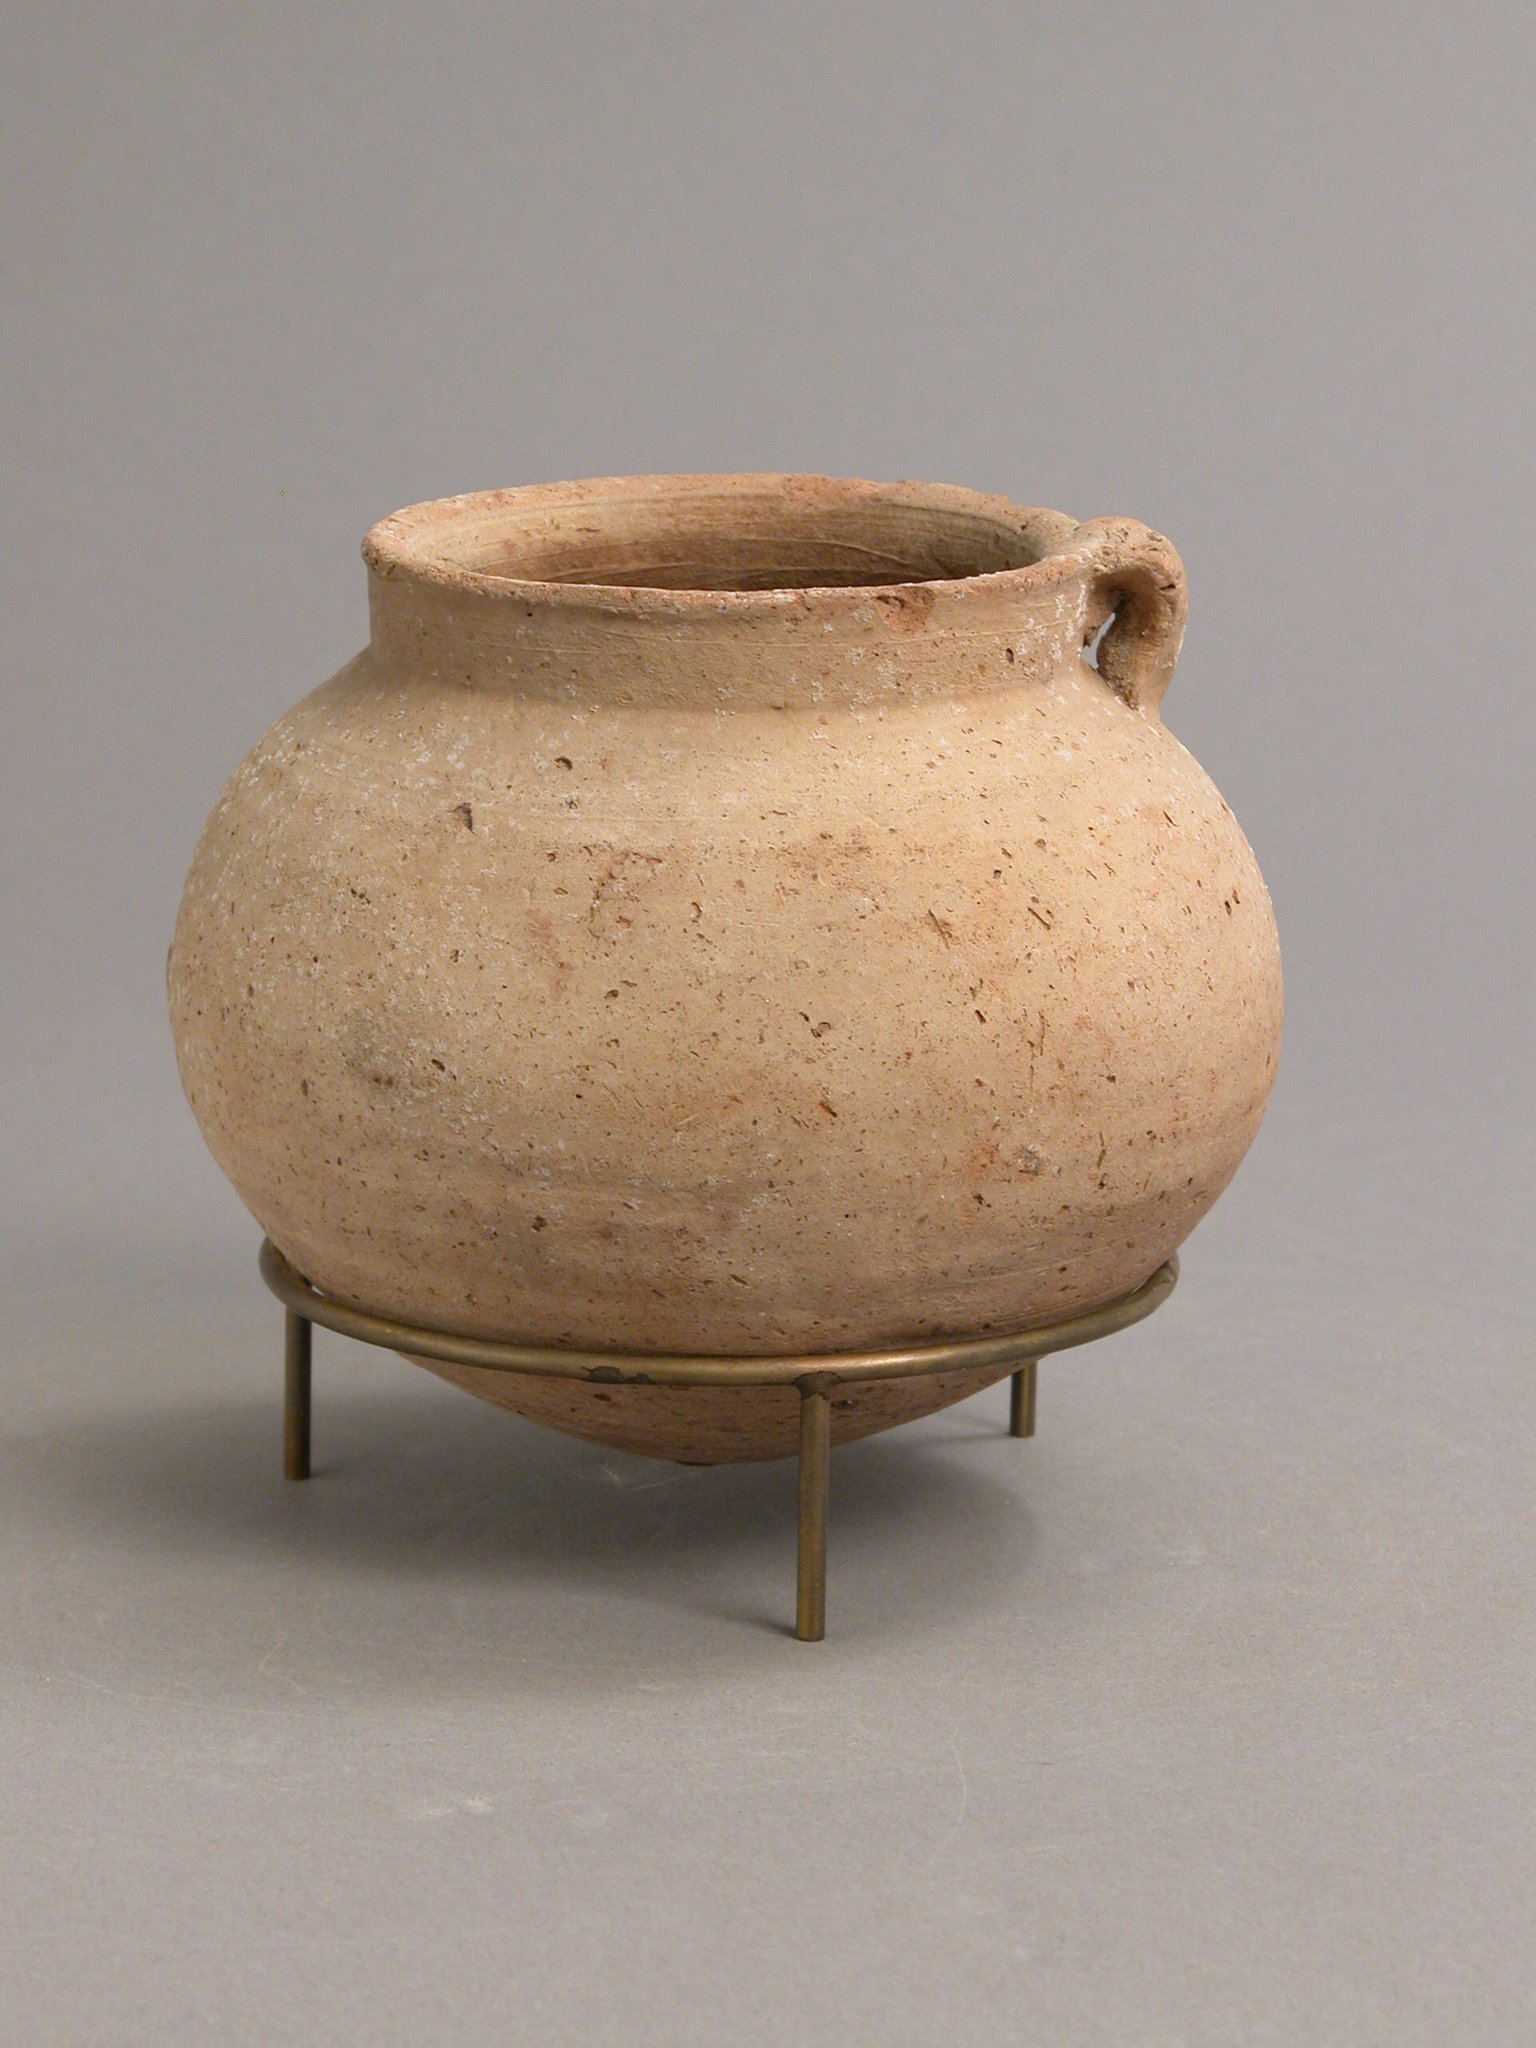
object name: jar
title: Jar with Handle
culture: coptic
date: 301-700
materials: earthenware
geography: egypt